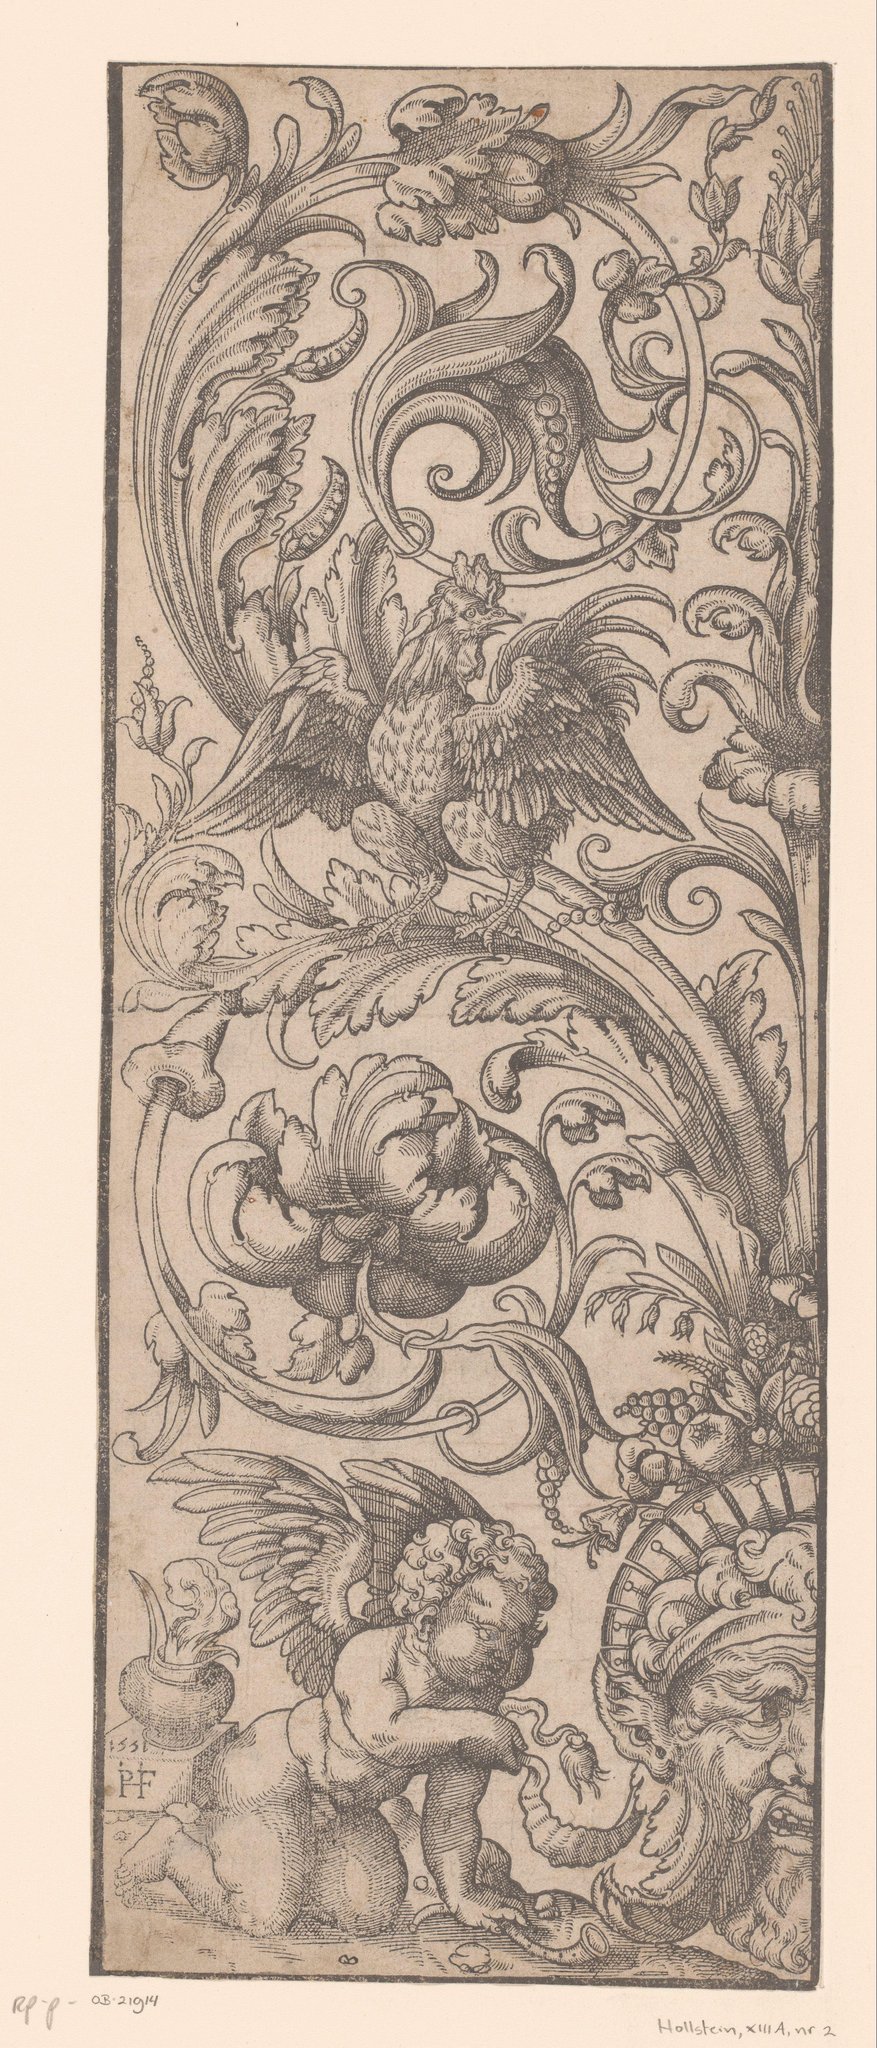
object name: ornament print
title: Ornament met een knielende putto en een haan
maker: peter hille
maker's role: print maker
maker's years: -1574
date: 1551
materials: paper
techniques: woodcut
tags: fowl (cock, hen, chicken, etc.), cupids: 'amores', 'amoretti', 'putti', ornament derived from plant forms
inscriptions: collector's mark: Lugt 240